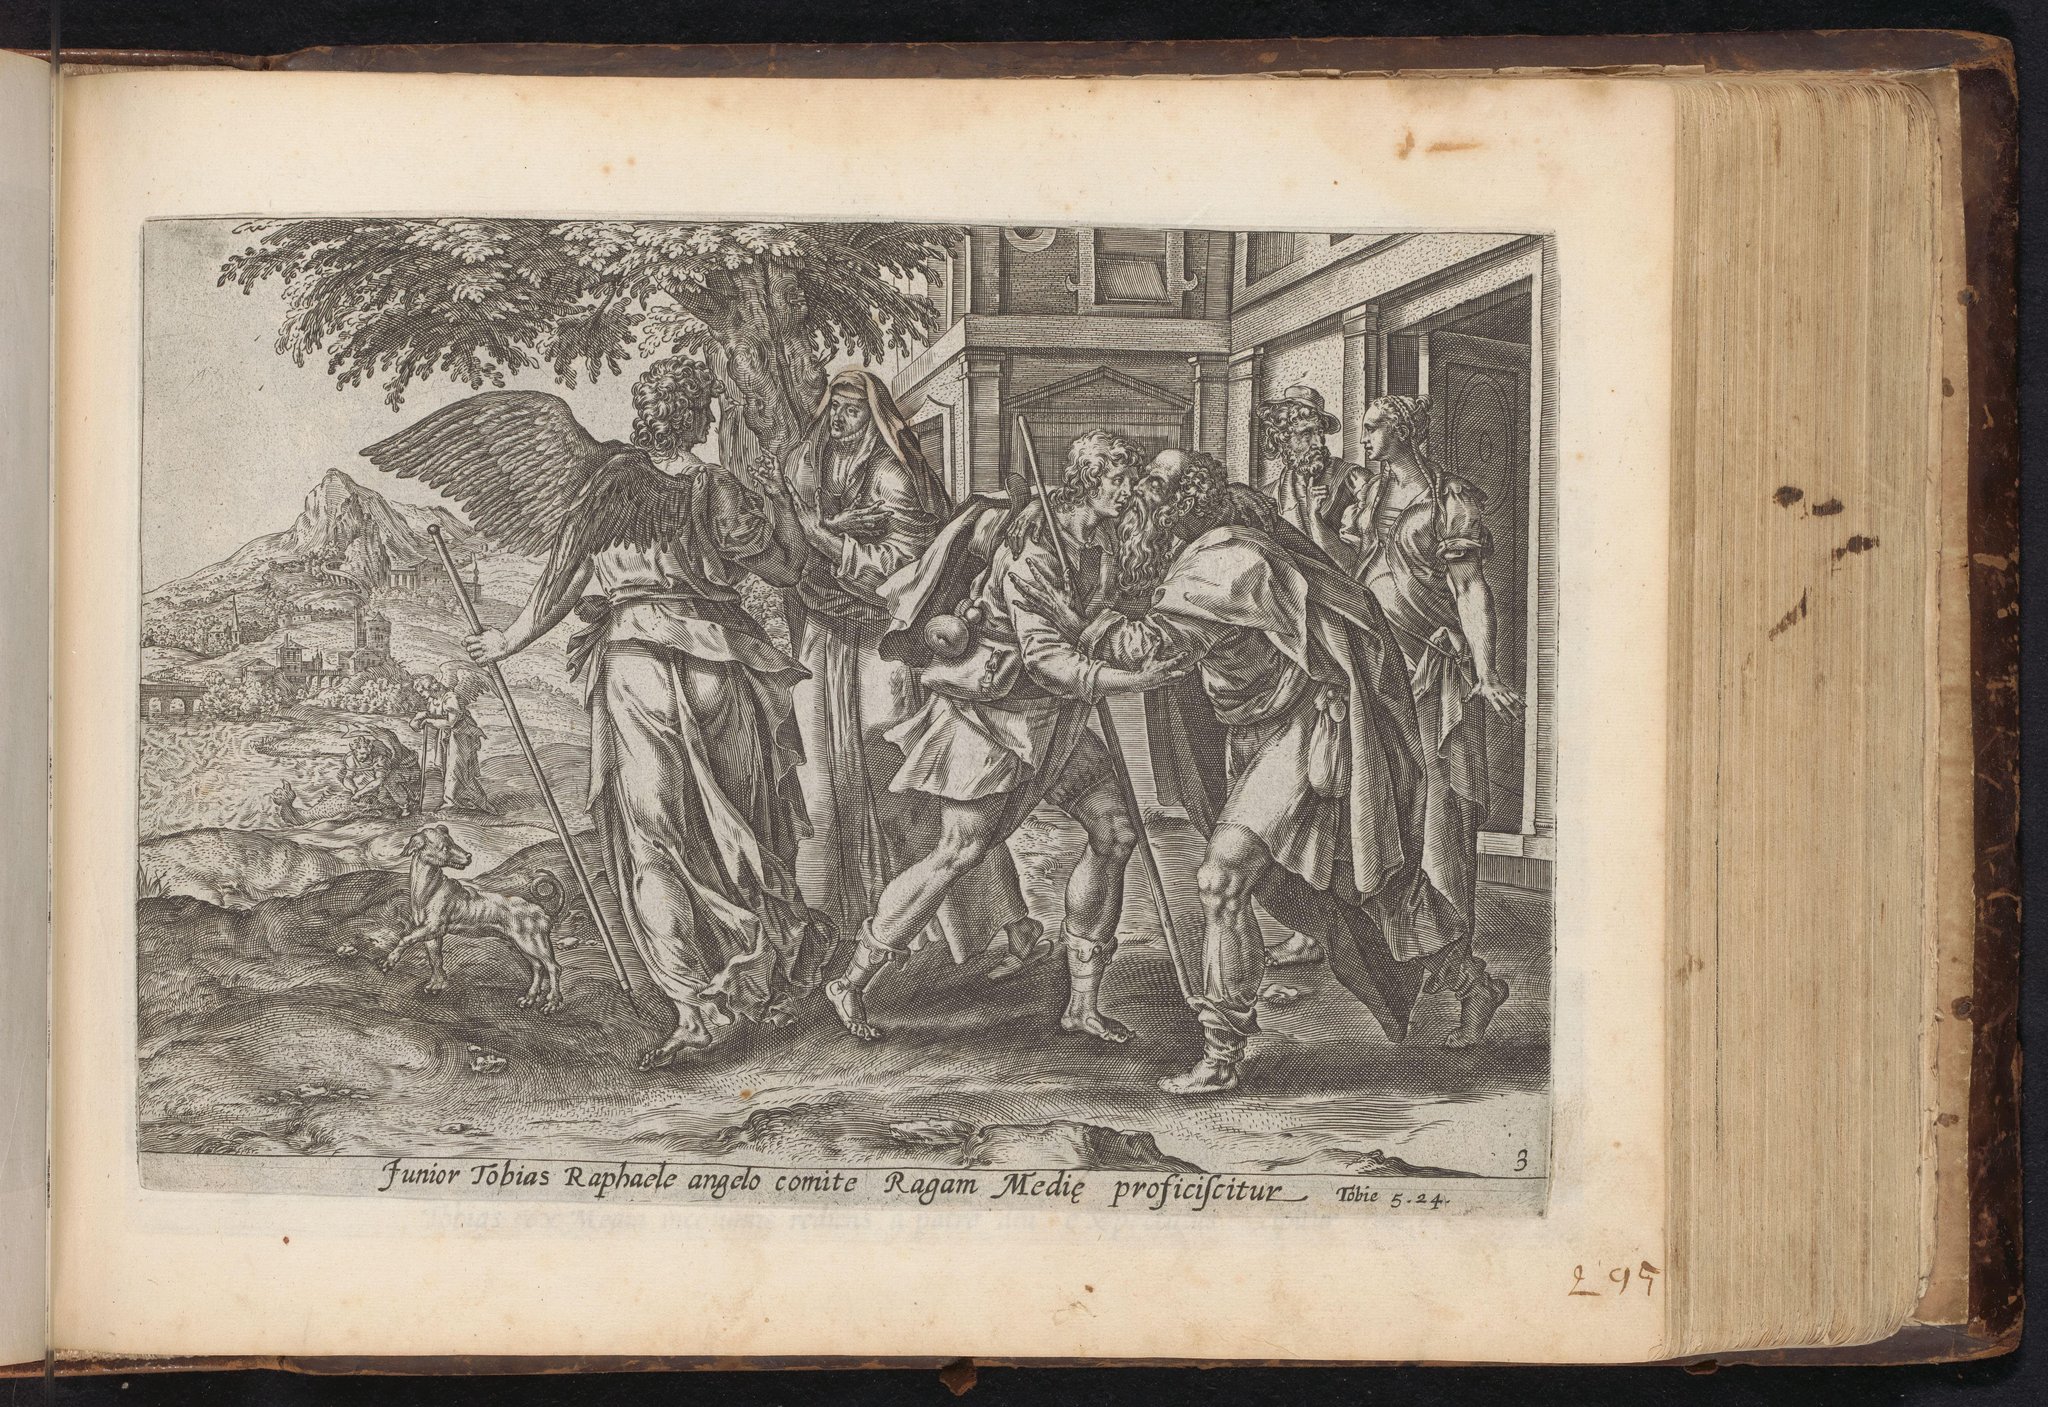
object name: album leaf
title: Tobias en de engel nemen afscheid van Tobit en Anna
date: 1585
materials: paper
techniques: engraving, hand coloring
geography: amsterdam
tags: tobias taking leave of his parents; anna mourns her son's departure, the angel raphael tells tobias to cut the fish to pieces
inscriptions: number: ‘295’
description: Tobias en de engel Rafaël nemen afscheid van Tobias' ouders Tobit en Anna. Rechtsachter Tobias en de engel bij de rivier de Tigris waar Tobias het hart, de lever en de gal van de gevangen vis verwijdert en meeneemt. Onder de voorstelling een verwijzing in het Latijn naar de Bijbeltekst in Tobit. 5:24. Deze prent maakt deel uit van een album.